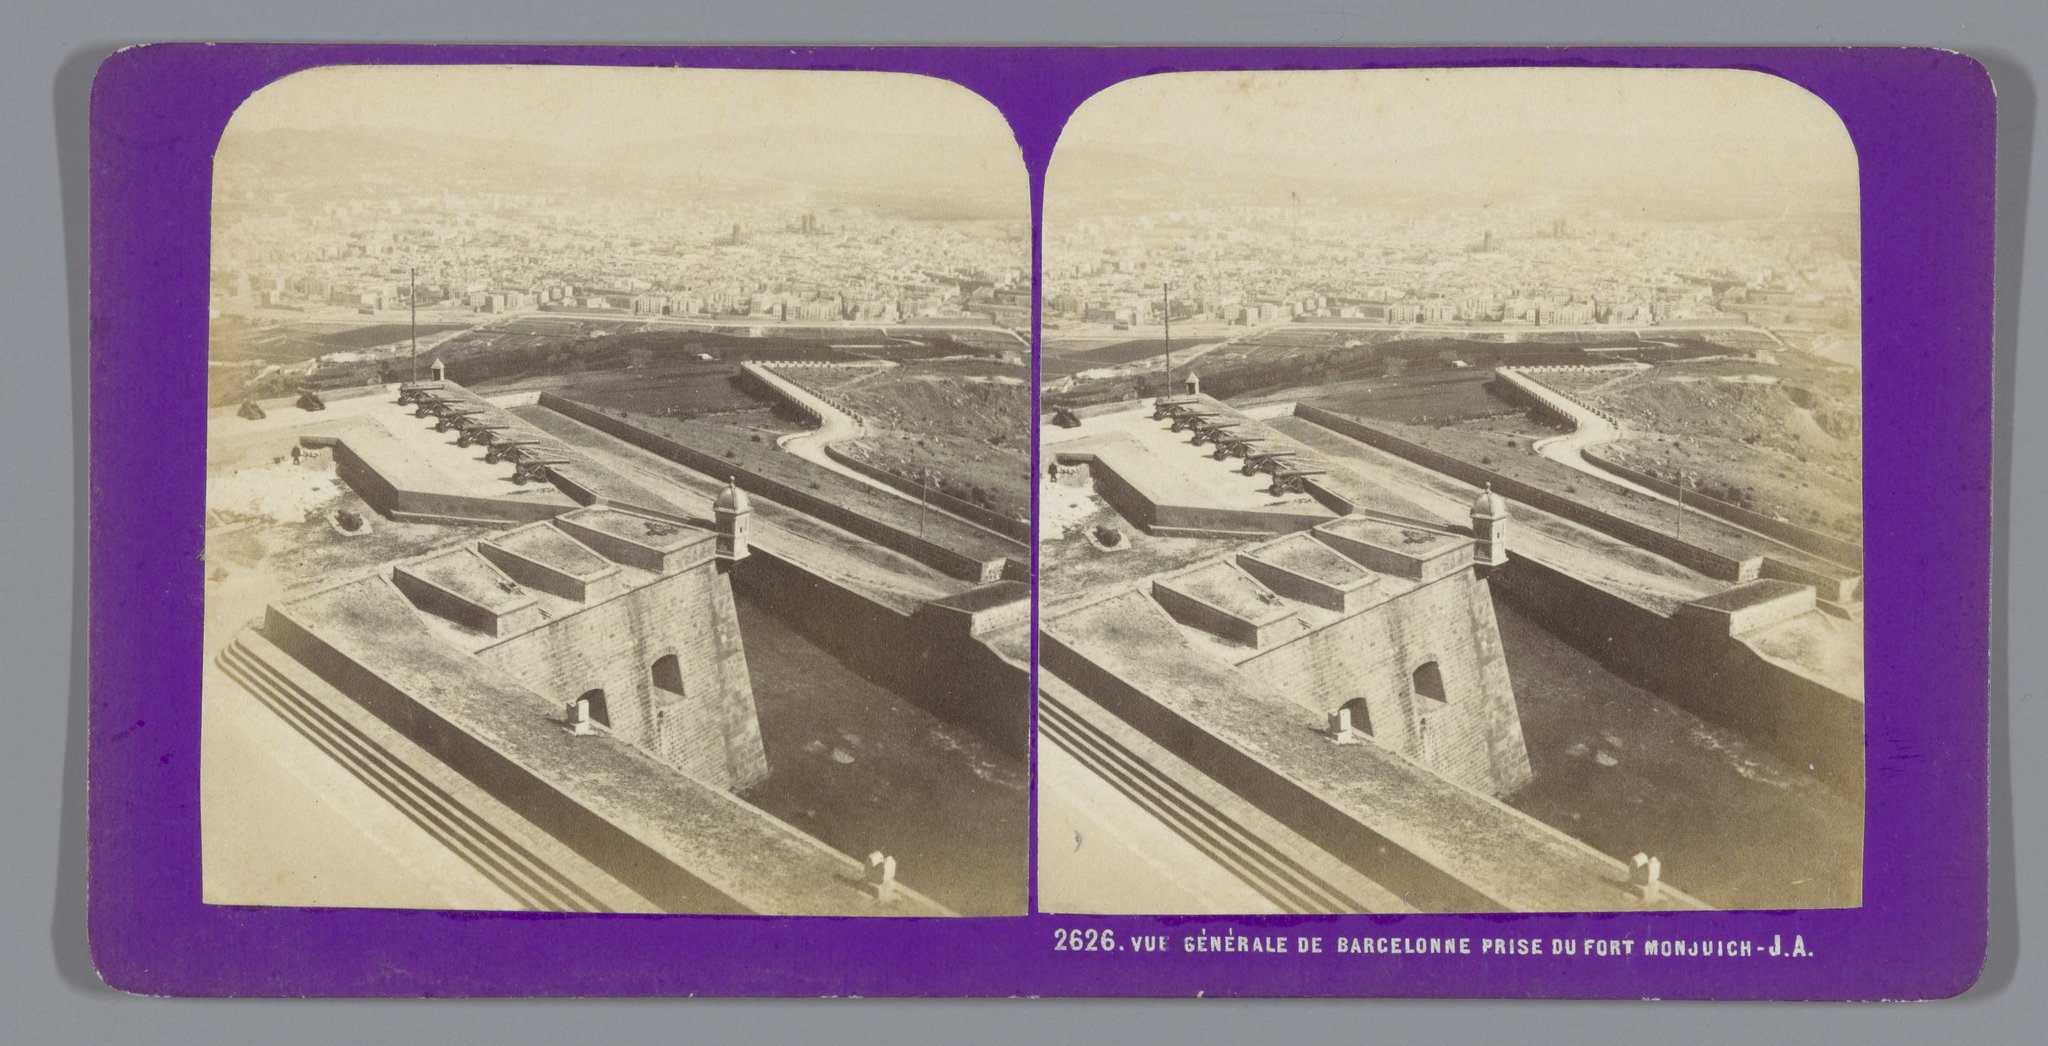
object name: stereograph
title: VUE GÉNÉRALE DE BARCELONE PRISE DU FORT MONJUICH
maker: jean andrieu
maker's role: fotograaf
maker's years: 1816-1872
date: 1862-1876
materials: cardboard, photographic support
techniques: albumen print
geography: montjuïc castle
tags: city-view in general; 'veduta'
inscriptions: number: ‘2626.’